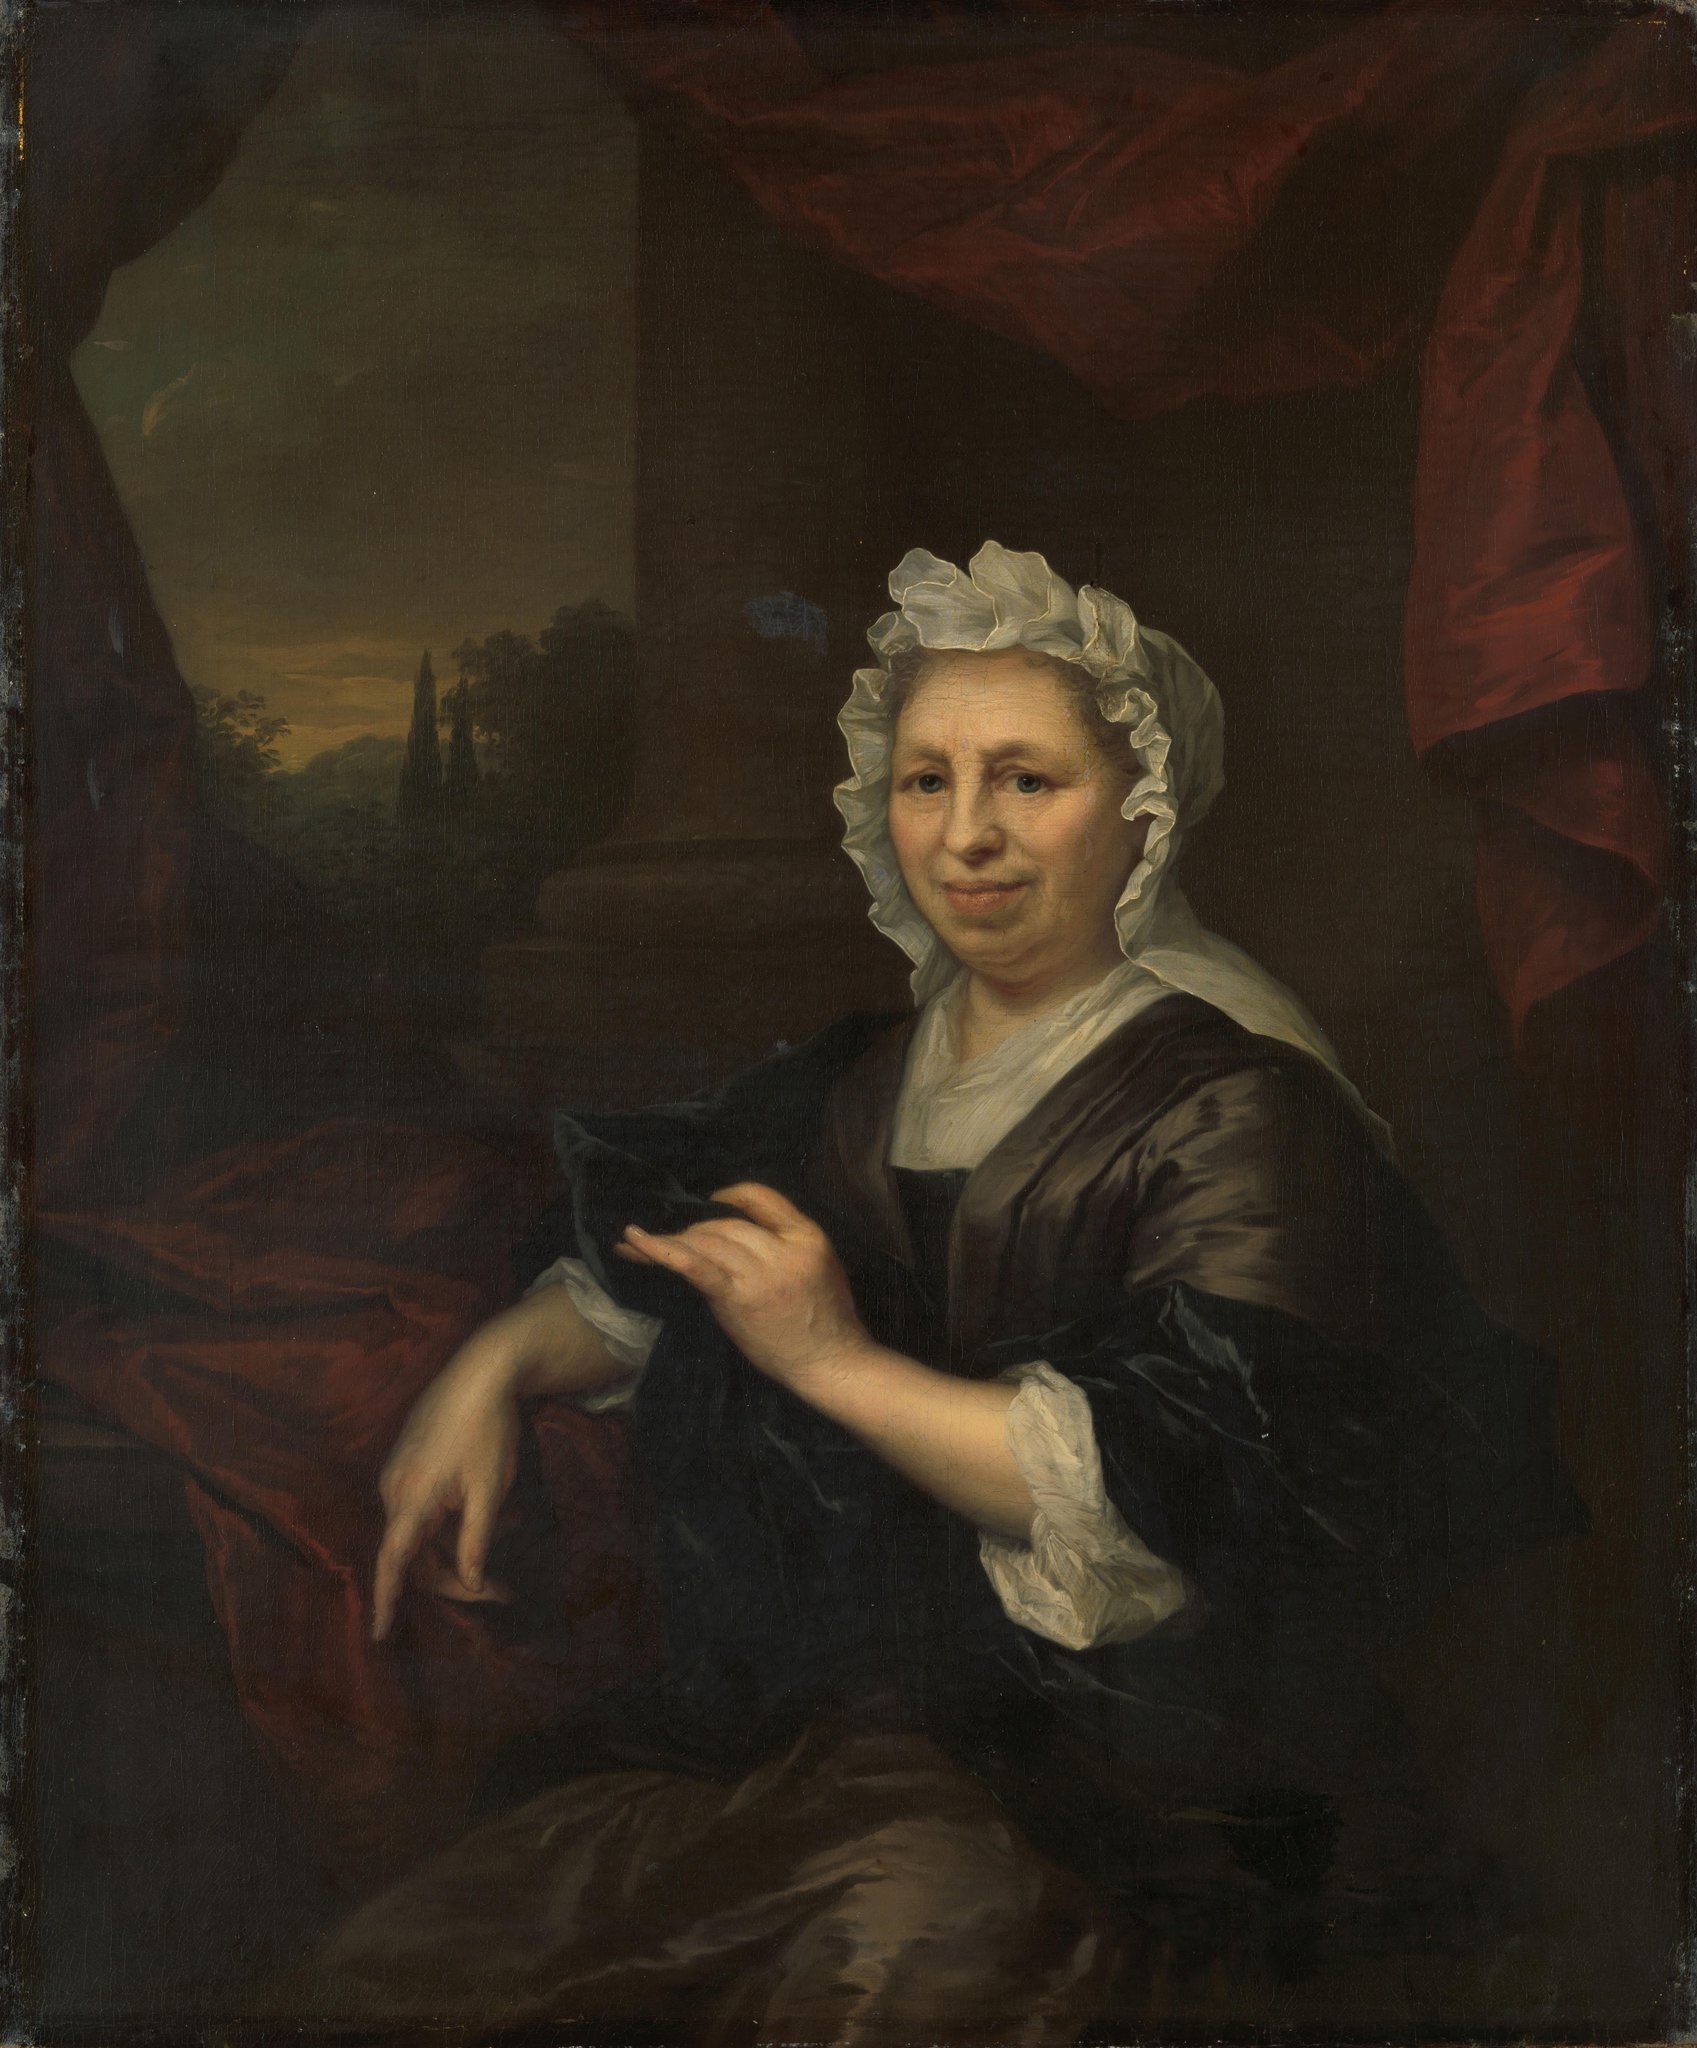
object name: painting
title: Brechje Hooft (1640-1721). Widow of Harmen van de Poll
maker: arnold boonen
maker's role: draughtsman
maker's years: 1669-1729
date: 1700-1729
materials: canvas, oil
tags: historical persons - bb - woman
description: Portret van Brechje Hooft, weduwe van Harmen van de Poll. Kniestuk, zittend.